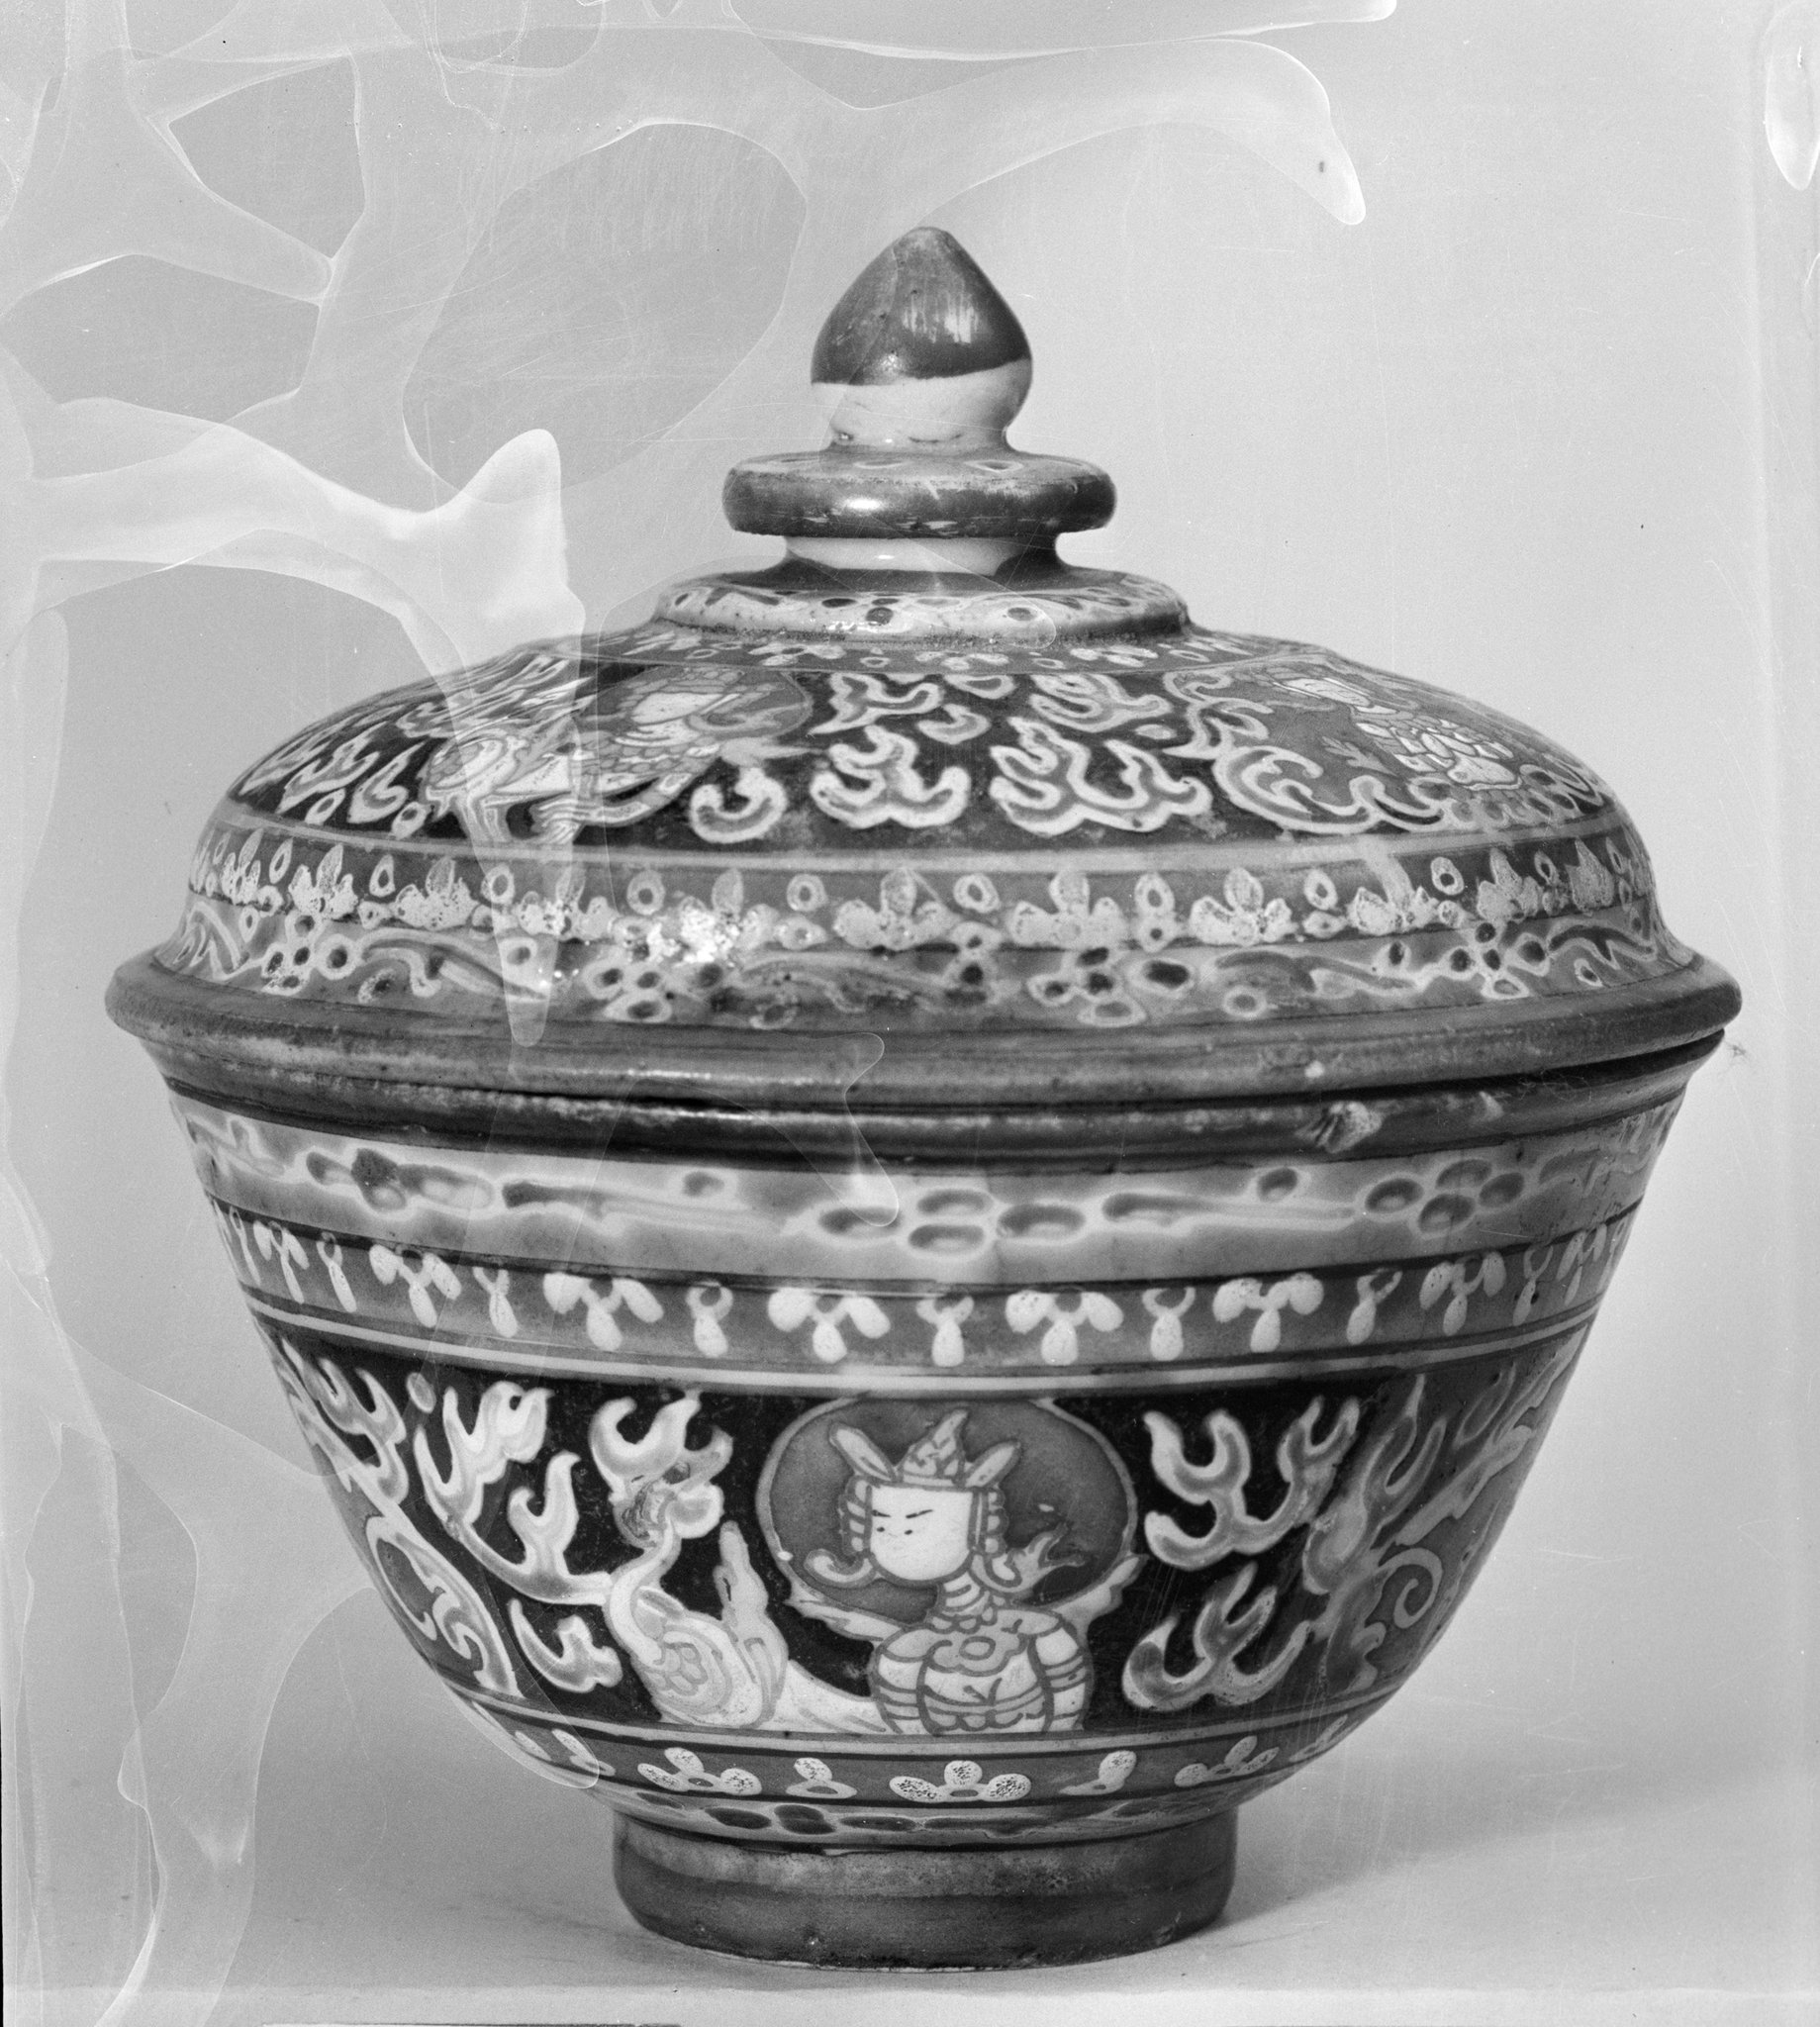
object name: covered jar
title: Covered jar with Thai mythical figures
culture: chinese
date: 1801-1900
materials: enamel, porcelain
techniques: overglaze, painting, polychrome